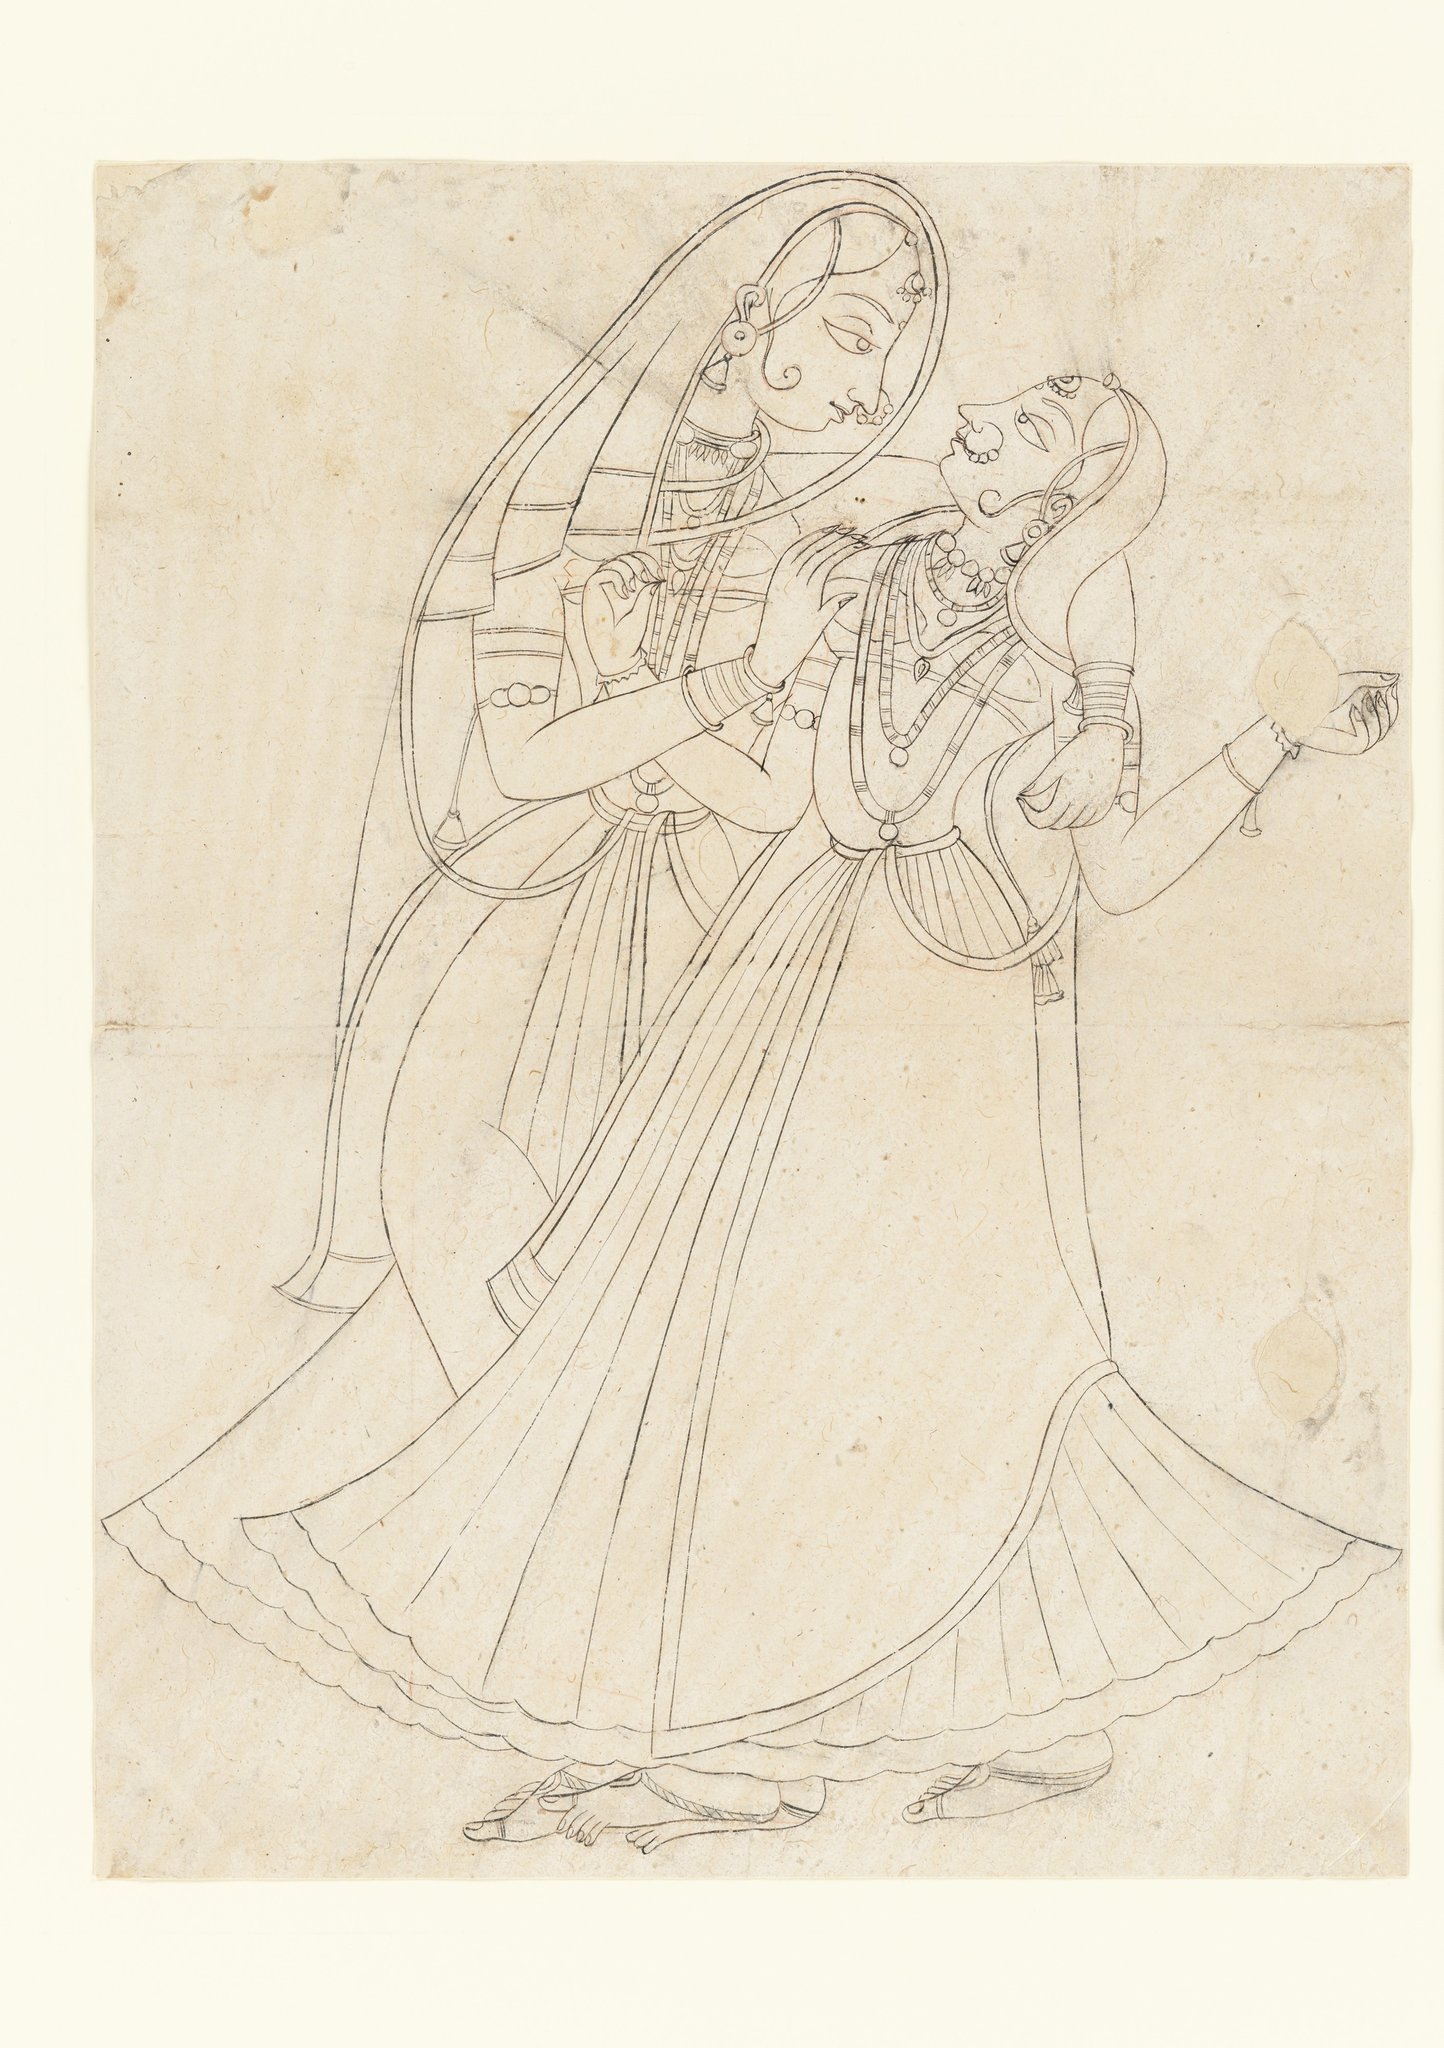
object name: painting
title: Krishna (dressed as a woman) Embracing Radha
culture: mewar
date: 1801-1900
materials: ink, paper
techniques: wash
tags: men,women,krishna,radha